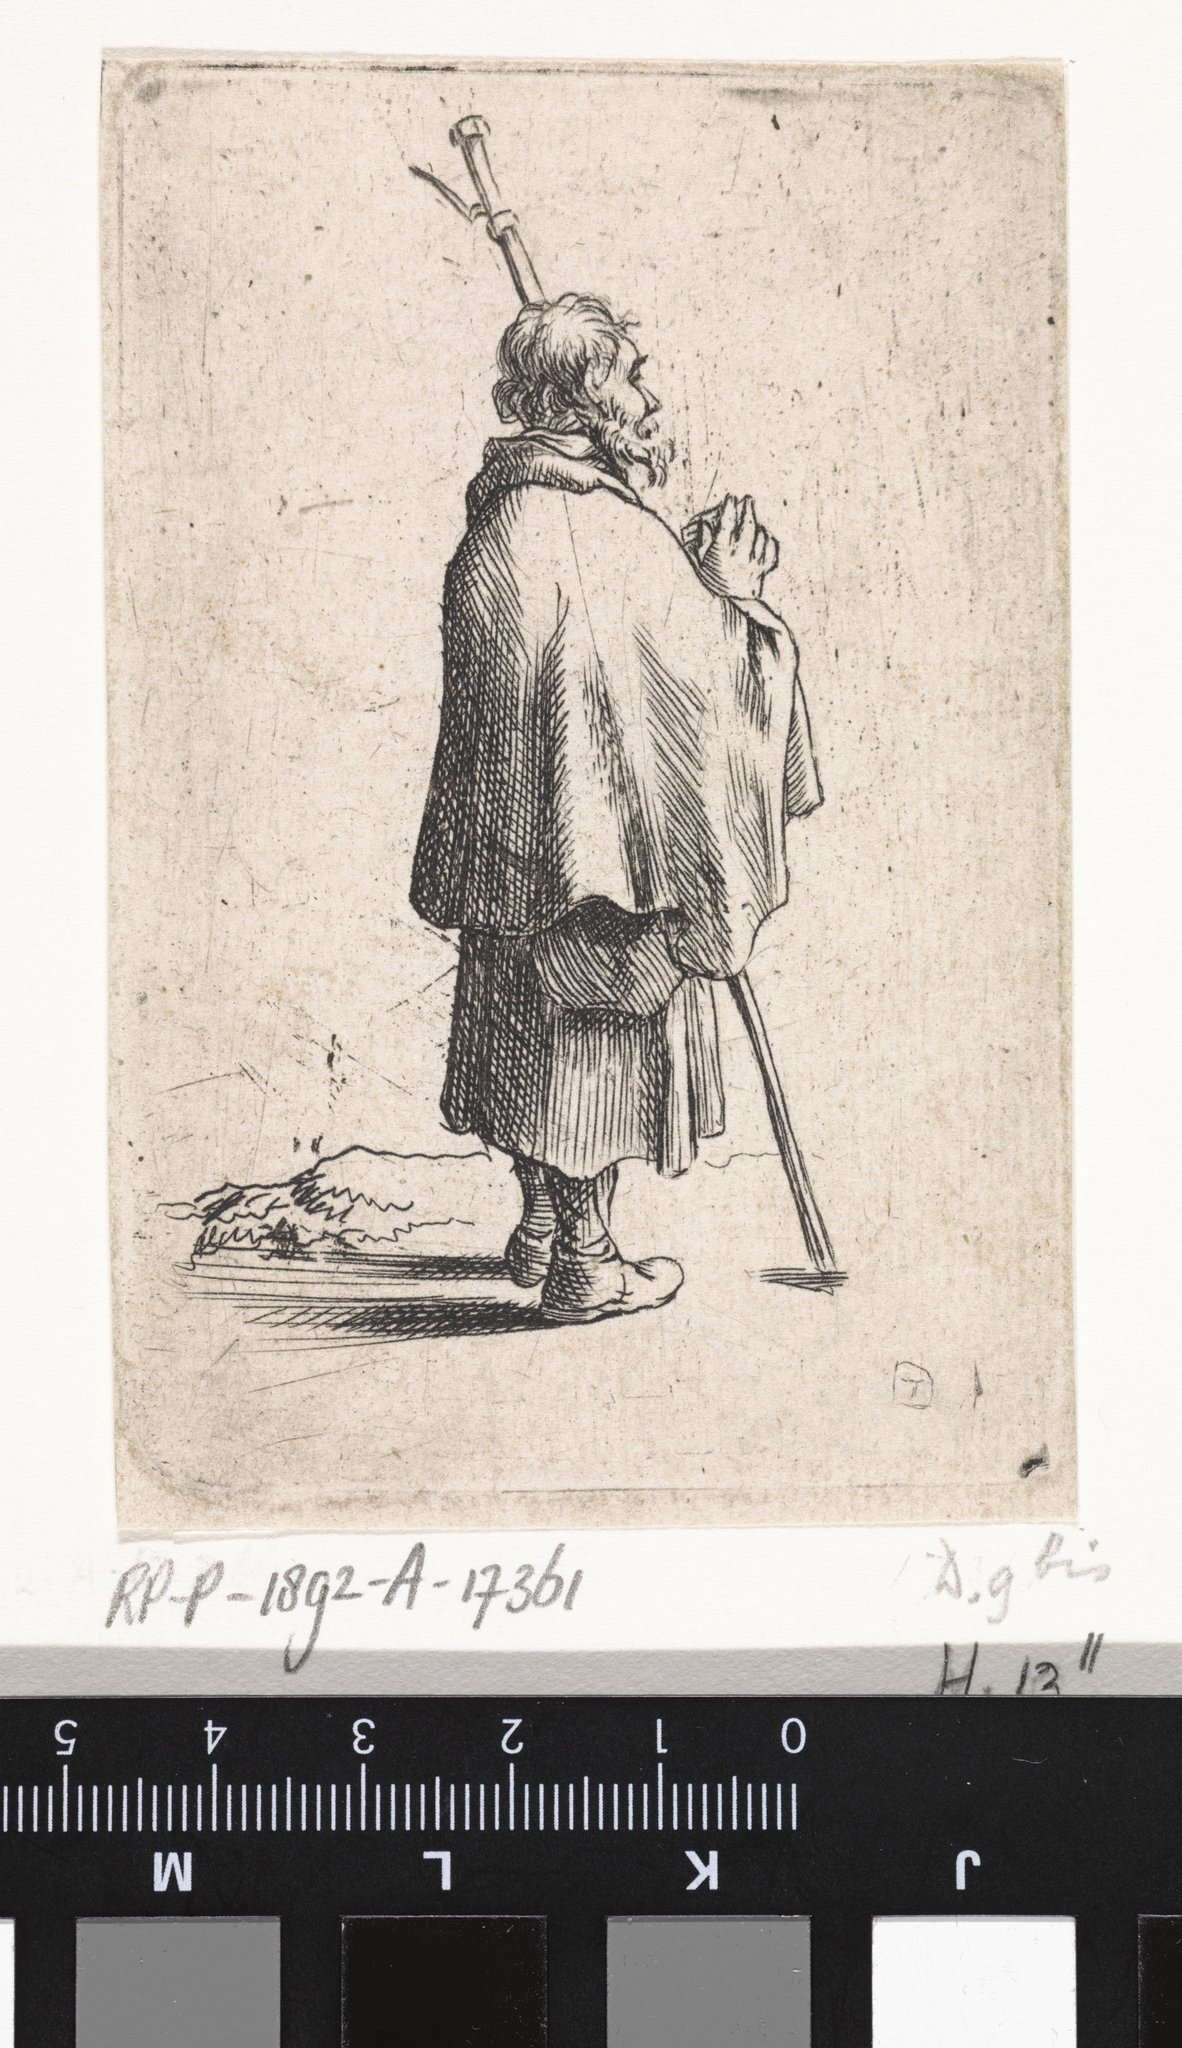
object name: print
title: Pelgrims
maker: david teniers (ii)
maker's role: draughtsman, painter, print maker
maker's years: 1610-1690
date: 1626-1690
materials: paper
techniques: etching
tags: pilgrim(s), hands folded with fingers knit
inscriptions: collector's mark: Lugt 2228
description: Een pelgrim met een staf en gevouwen handen.